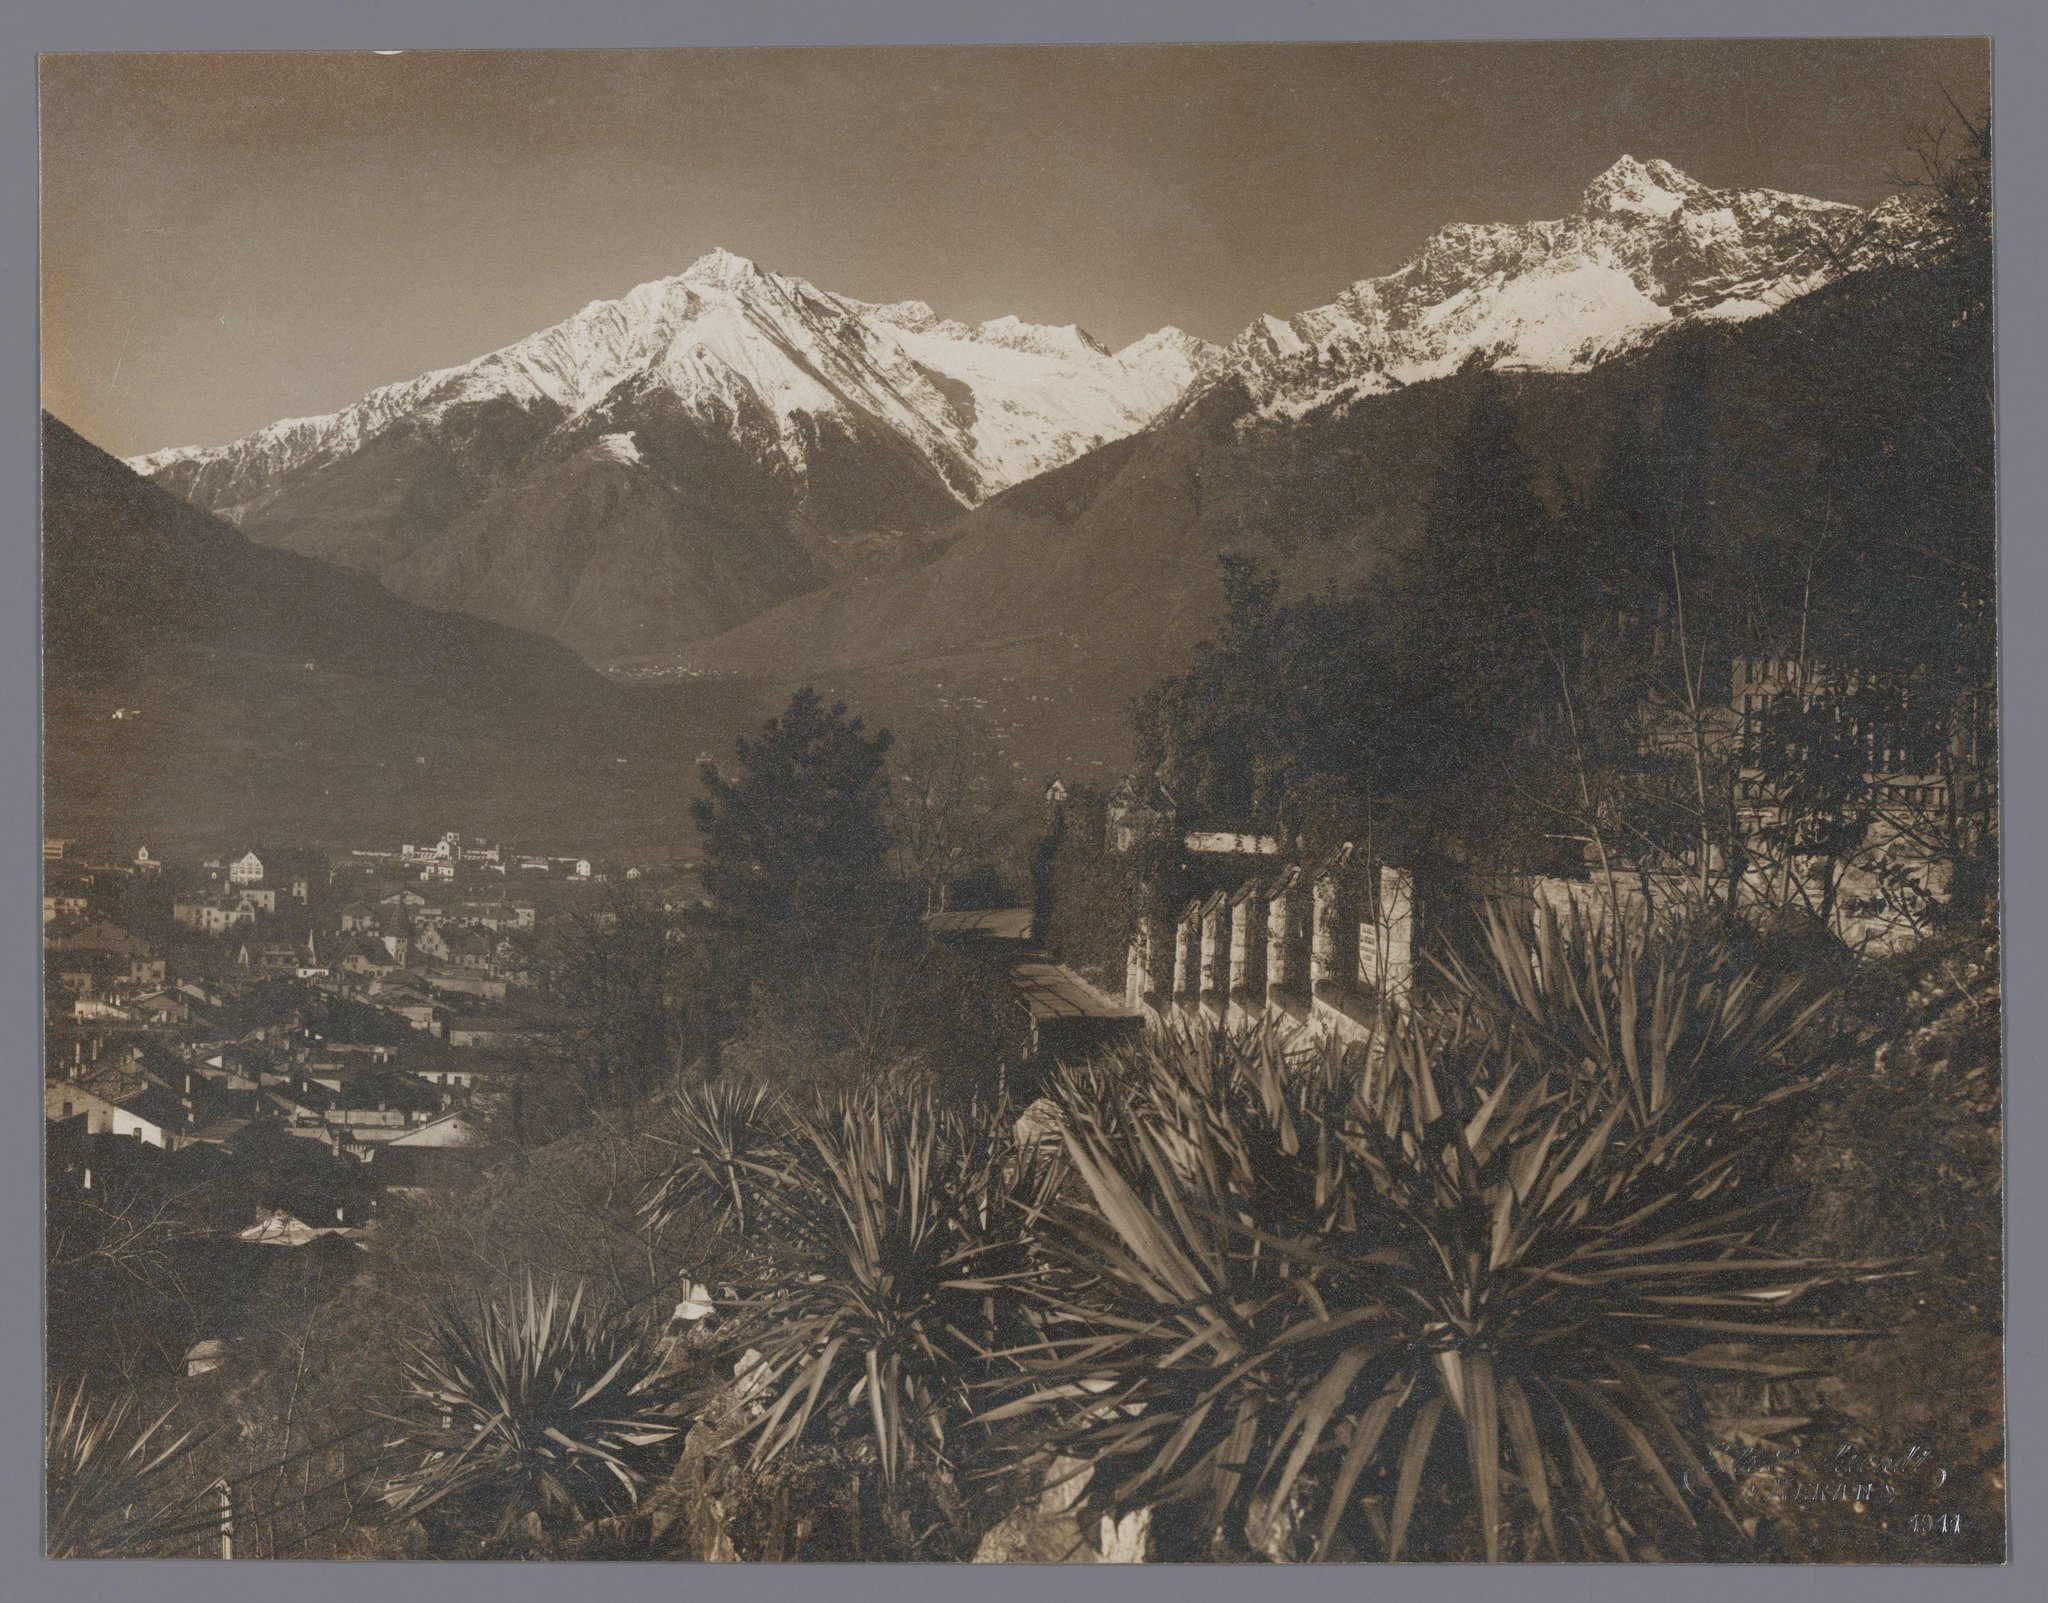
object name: photograph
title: Partie auf d. Tappeiner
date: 1911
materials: paper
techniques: gelatin silver print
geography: merano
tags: city-view in general; 'veduta'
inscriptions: number: ‘No 41 [?]’, number: ‘1911’